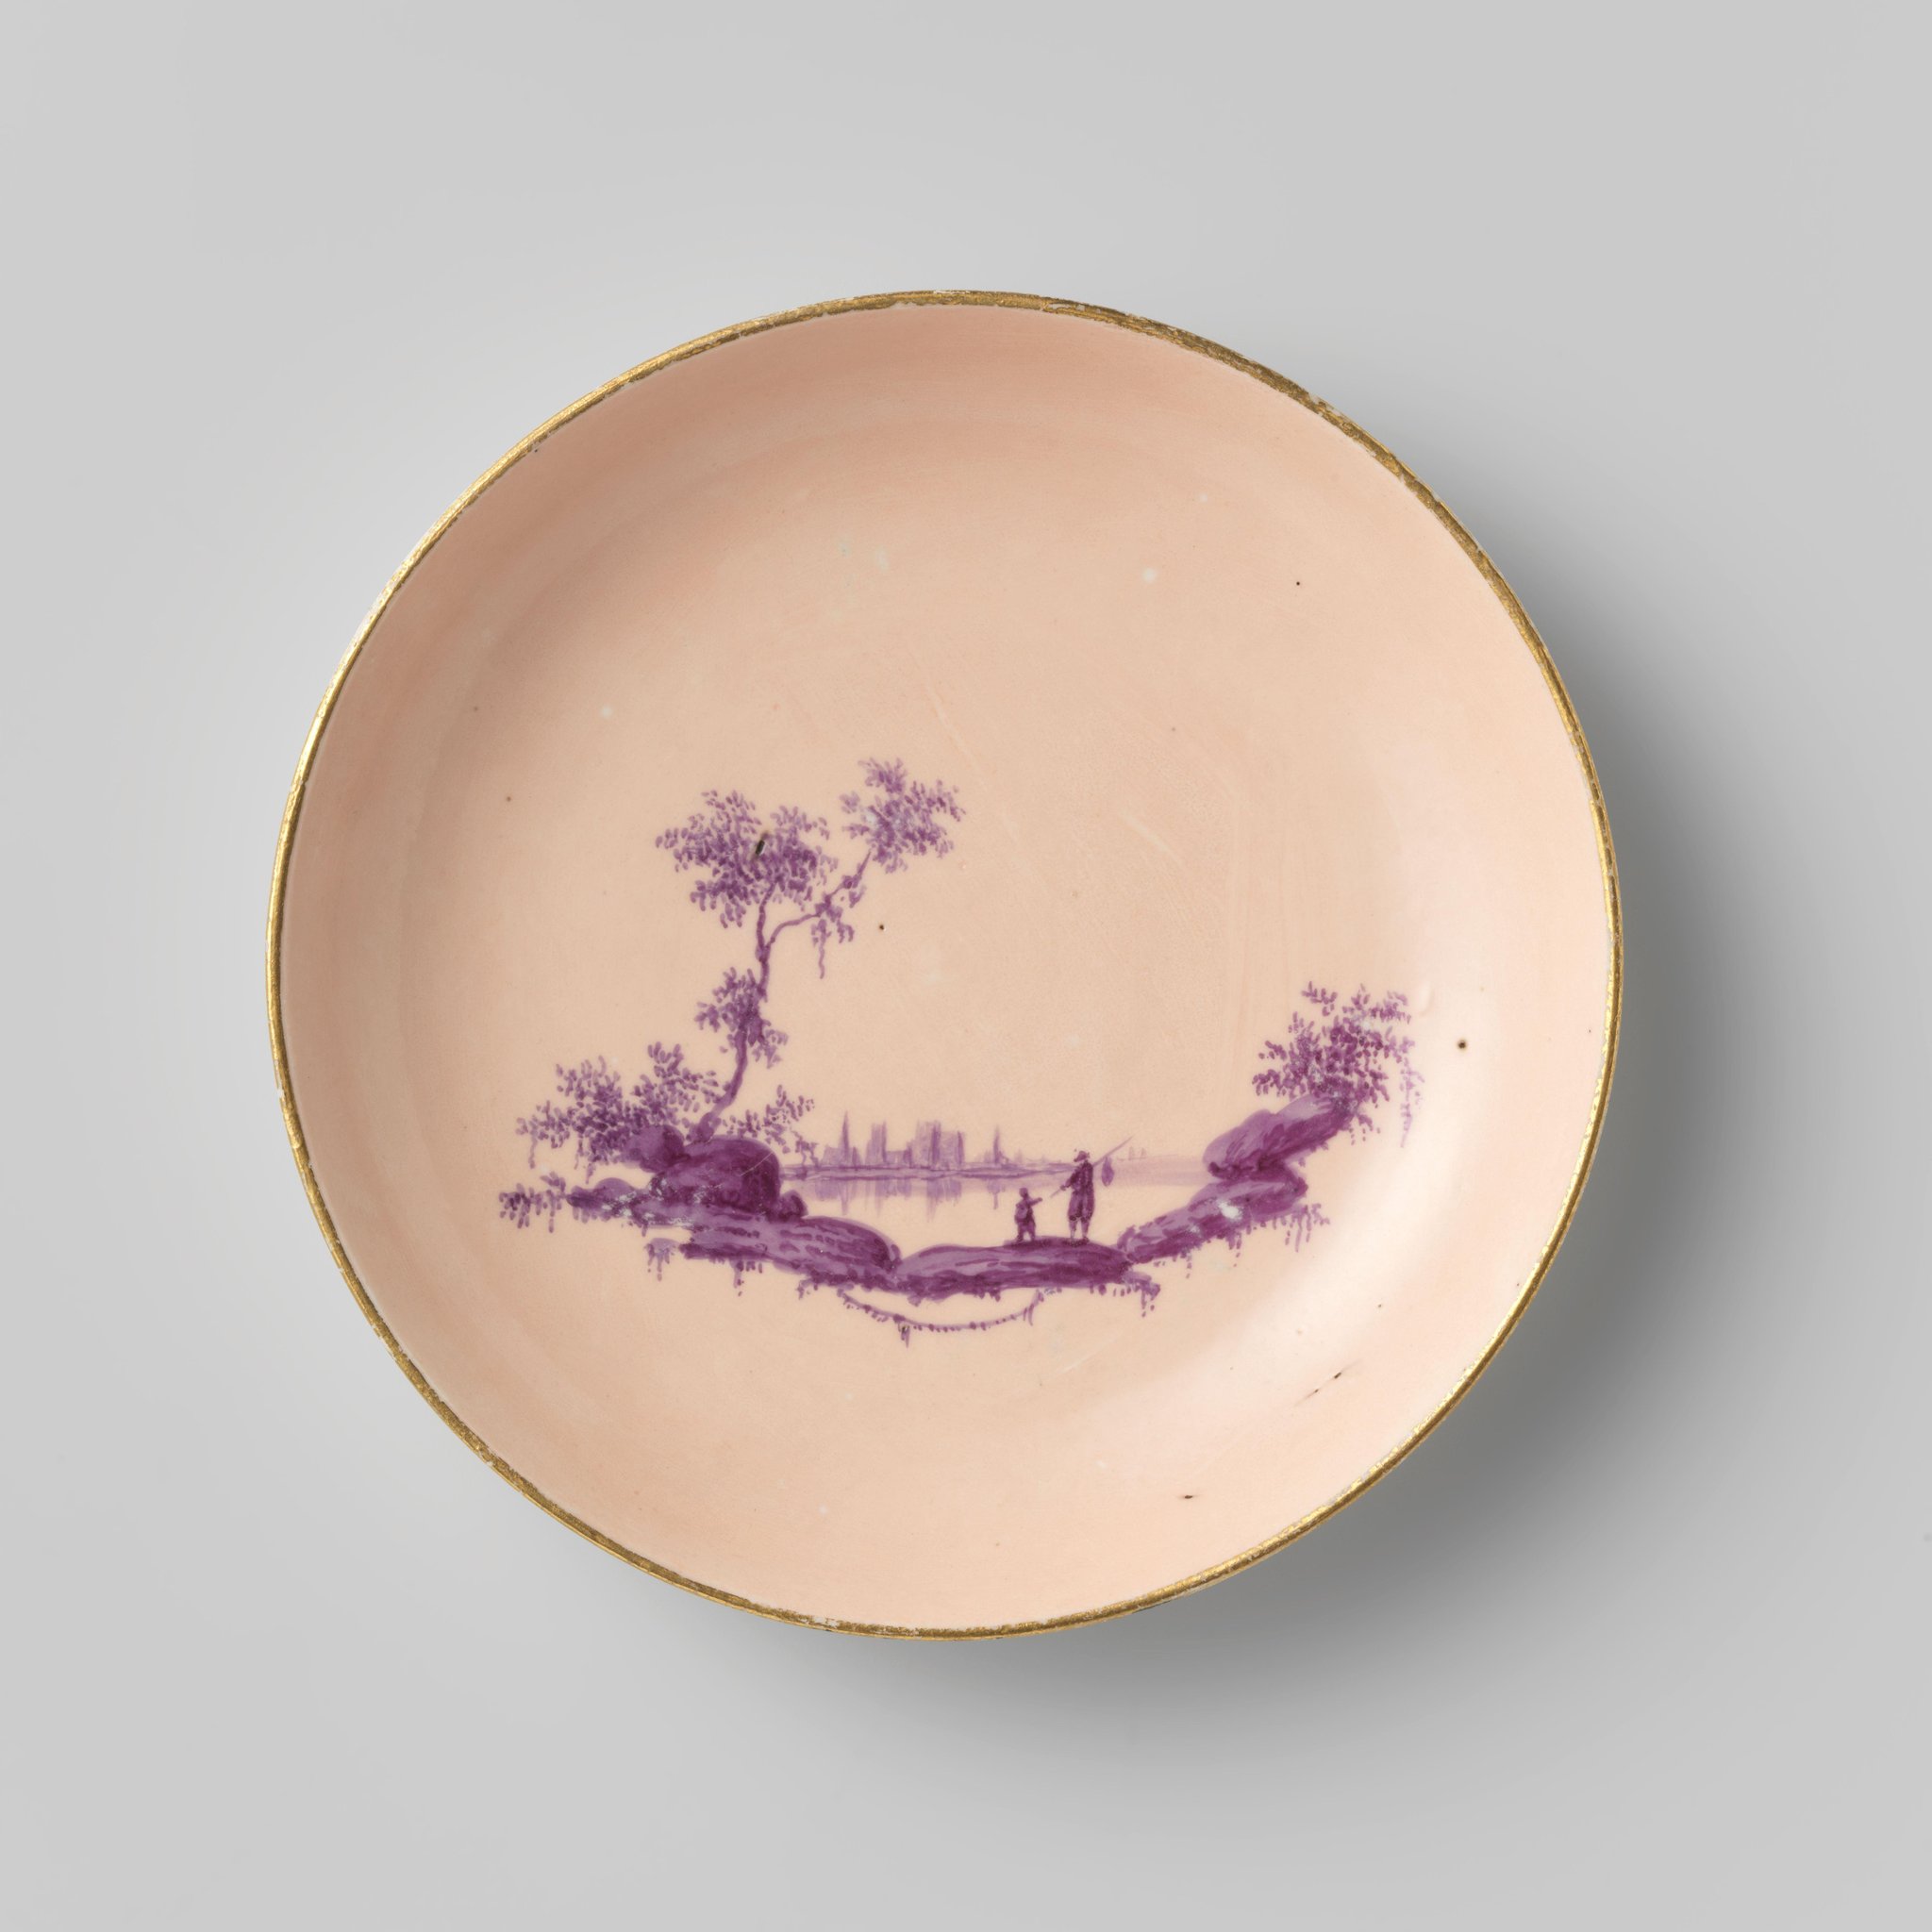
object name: platter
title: Schotel van een koffie- en theeservies, beschilderd met figuren in een rivierenlandschap in bietenrood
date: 1774-1778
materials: porcelain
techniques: painted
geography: loosdrecht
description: Parts of a tea and coffee service with pink ground. Porcelain. Loosdrecht, c. 1774 - 1776. Factory of Joannes de Mol.